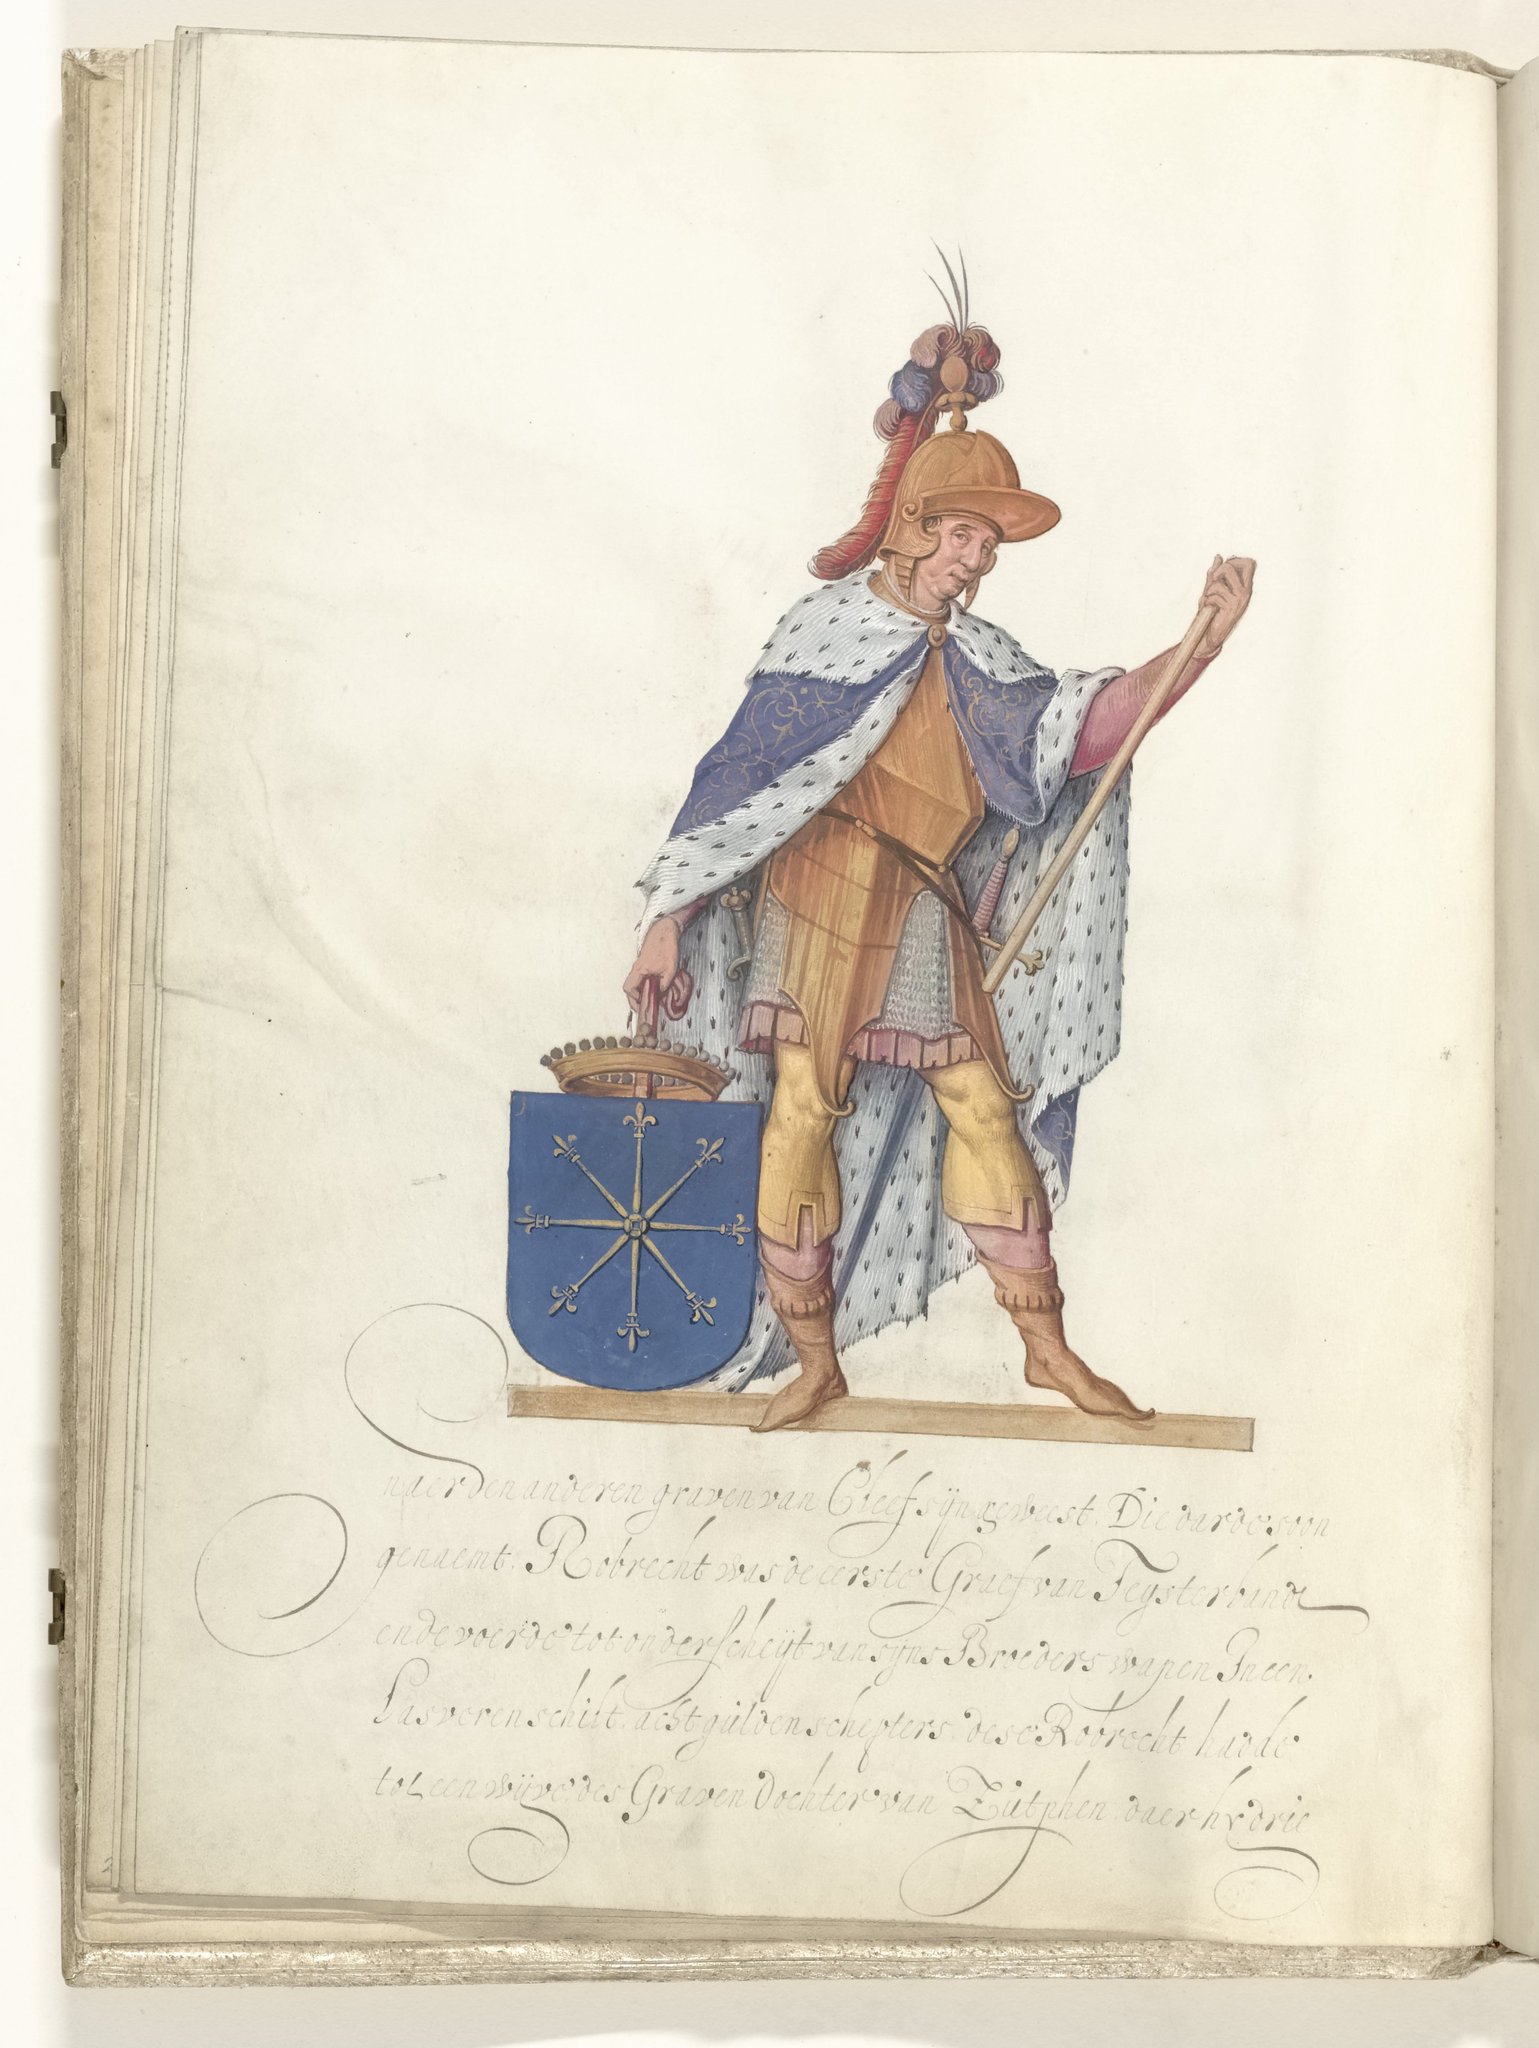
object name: drawing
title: Robbrecht van Teisterbant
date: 1590-1593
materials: paint, gouache, ink, parchment, watercolor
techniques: writing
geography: northern netherlands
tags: culemborg, heren en graven van, robbrecht graaf van teisterbant, graven van teisterbant, culemborg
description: De tekeningen worden op basis van archiefbronnen toegeschreven aan Nicolaes de Kemp (ca. 1550-1600) en worden gedateerd ca. 1590-1593. De teksten lijken gezien het handschrift begin 17de-eeuws.